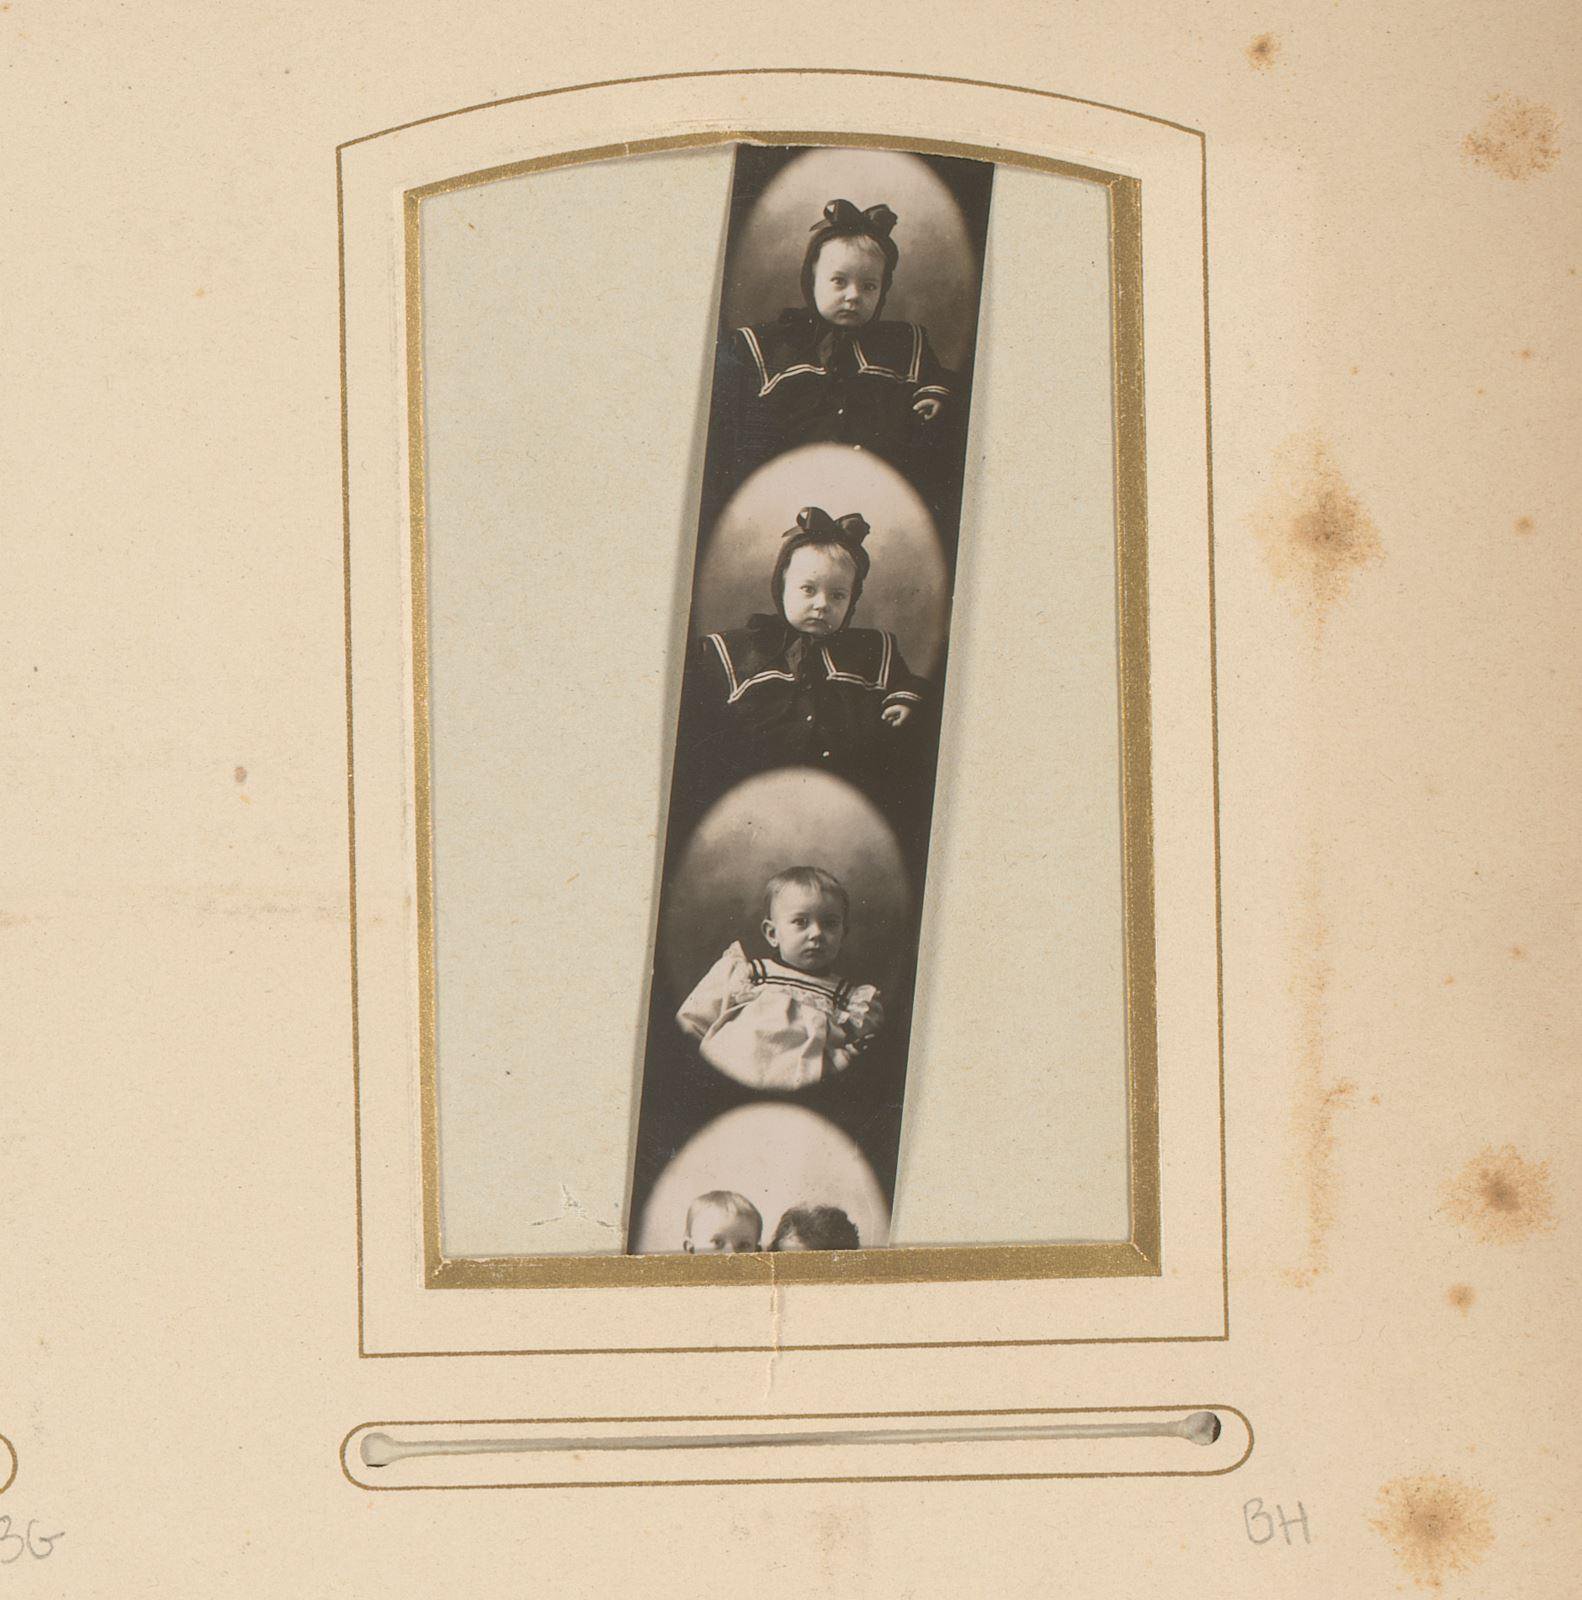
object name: photograph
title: Vier portretten van baby's, waarvan één portret met een vrouw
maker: Anonymous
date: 1915-1930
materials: photographic support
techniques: gelatin silver print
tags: adult woman, historical persons - bb - woman, historical persons, infant, baby ~ the ages of man